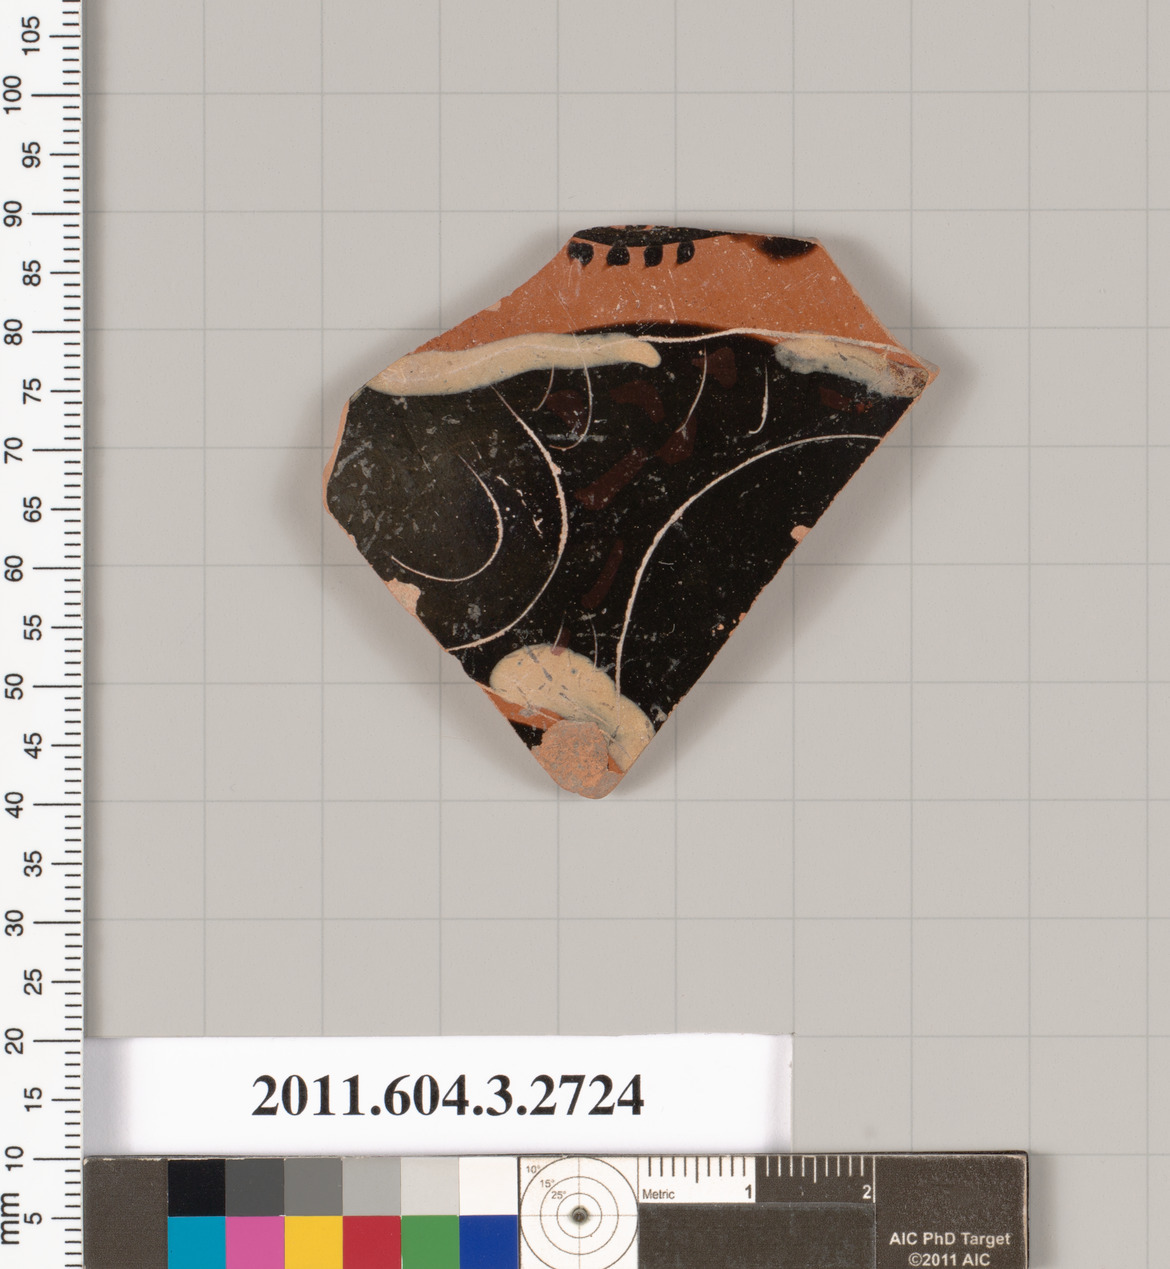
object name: oinochoe fragment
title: Terracotta fragment of an oinochoe (jug)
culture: greek, attic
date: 510-500 BCE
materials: terracotta